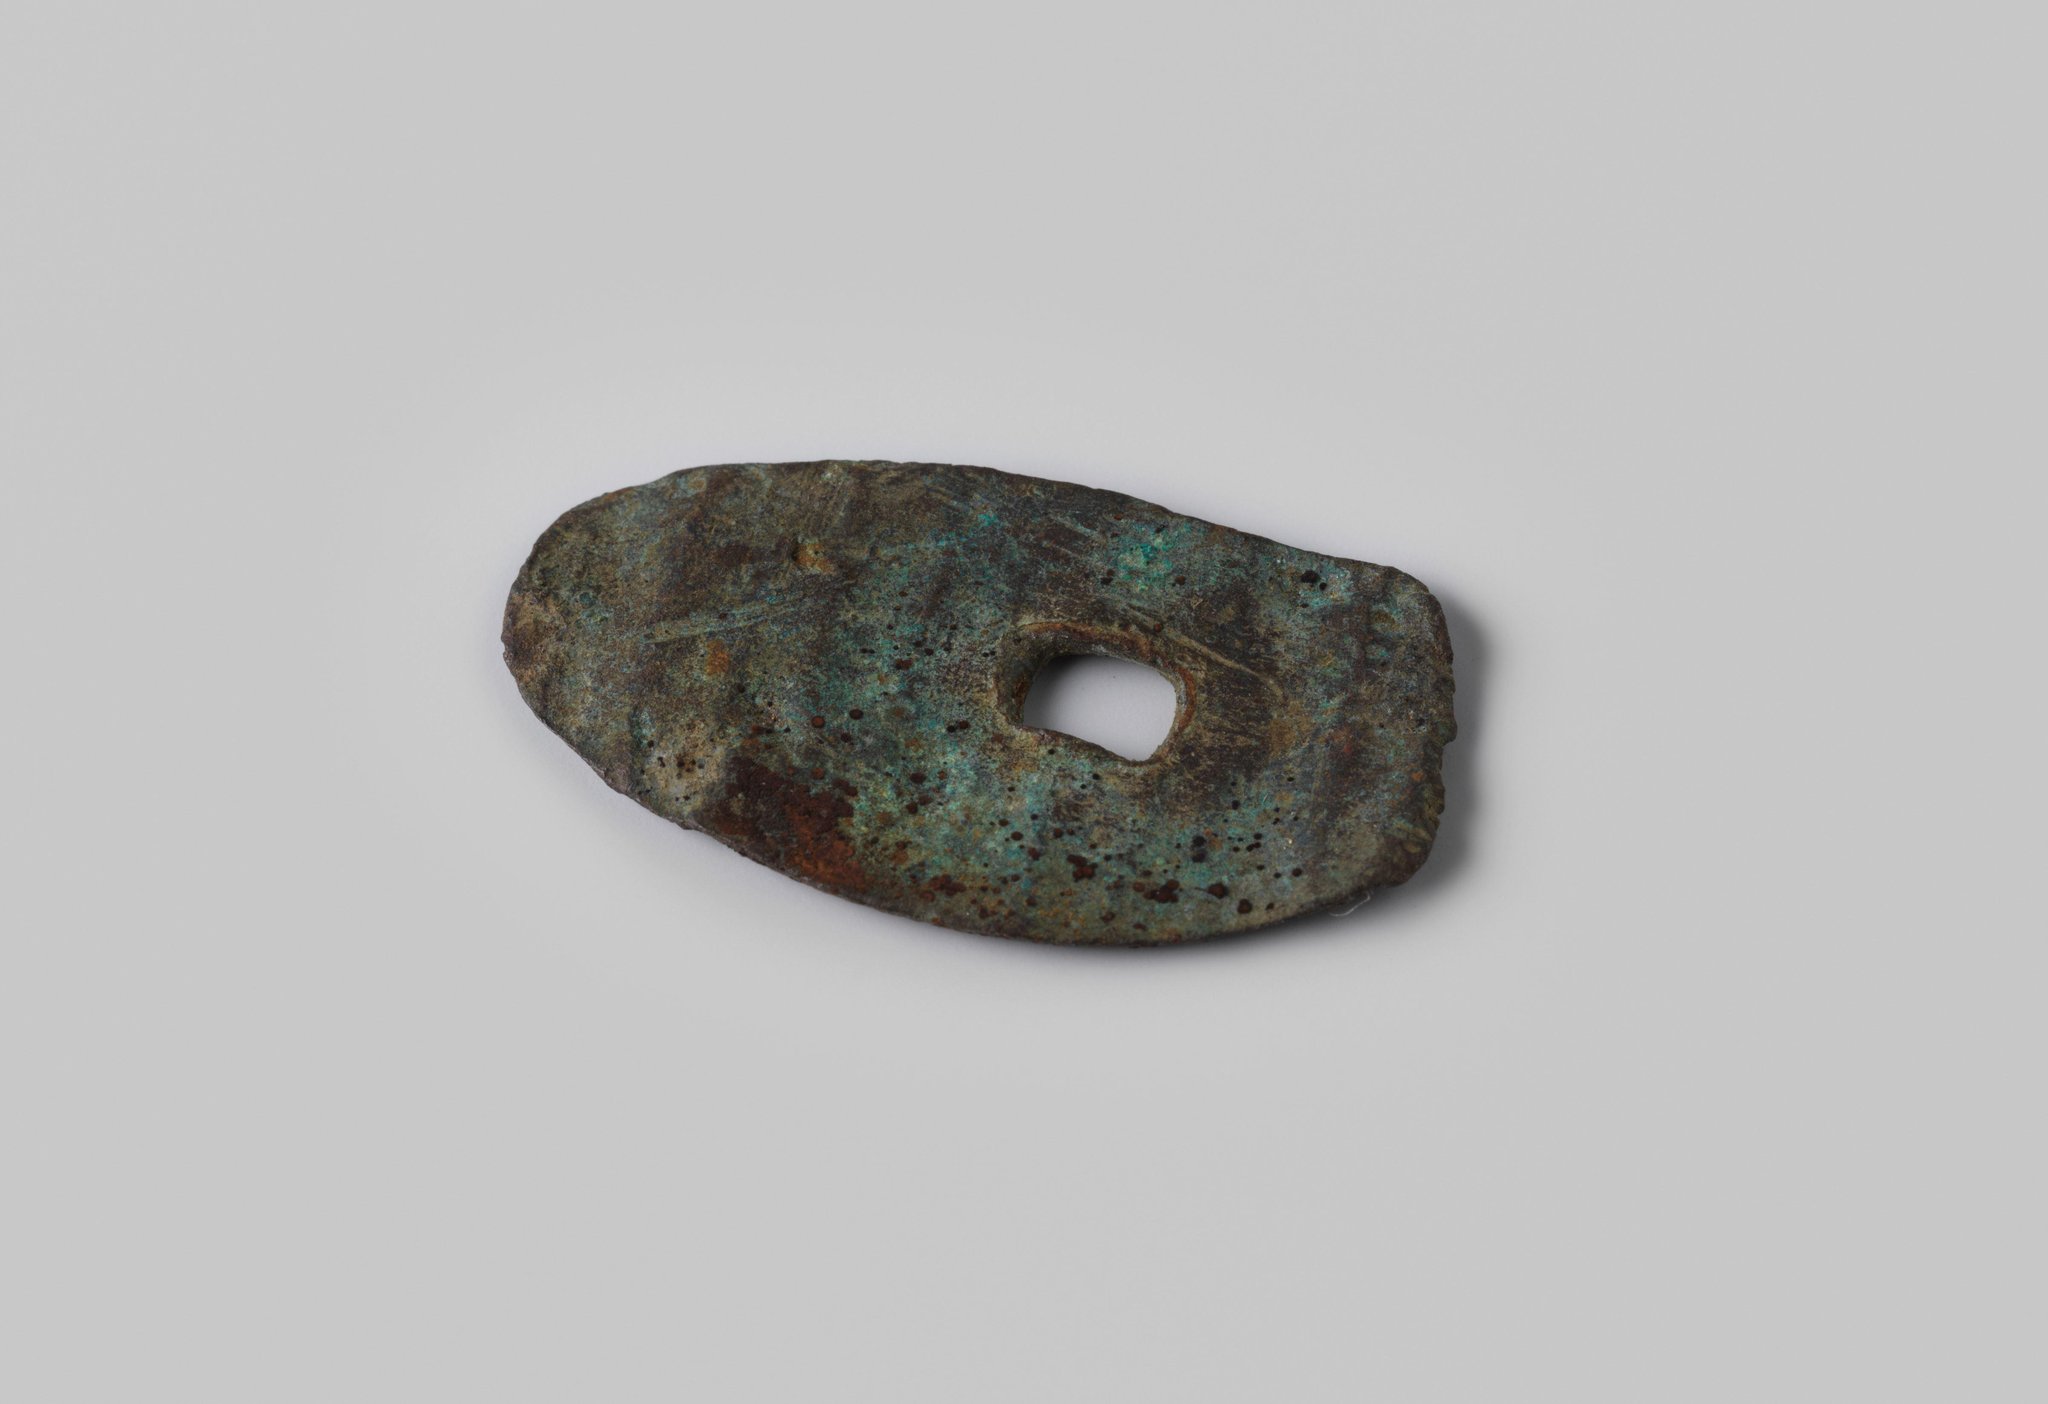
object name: sluitring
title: Fragment sluitring uit het wrak van de Oost-Indiëvaarder Hollandia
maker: Anonymous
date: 1700-1743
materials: copper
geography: netherlands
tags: verenigde oostindische compagnie, hollandia (schip), annet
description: Varied parts or fragments, washers; oval. sim. 80H164, flat, rectangular hole, bevelled outer rim.